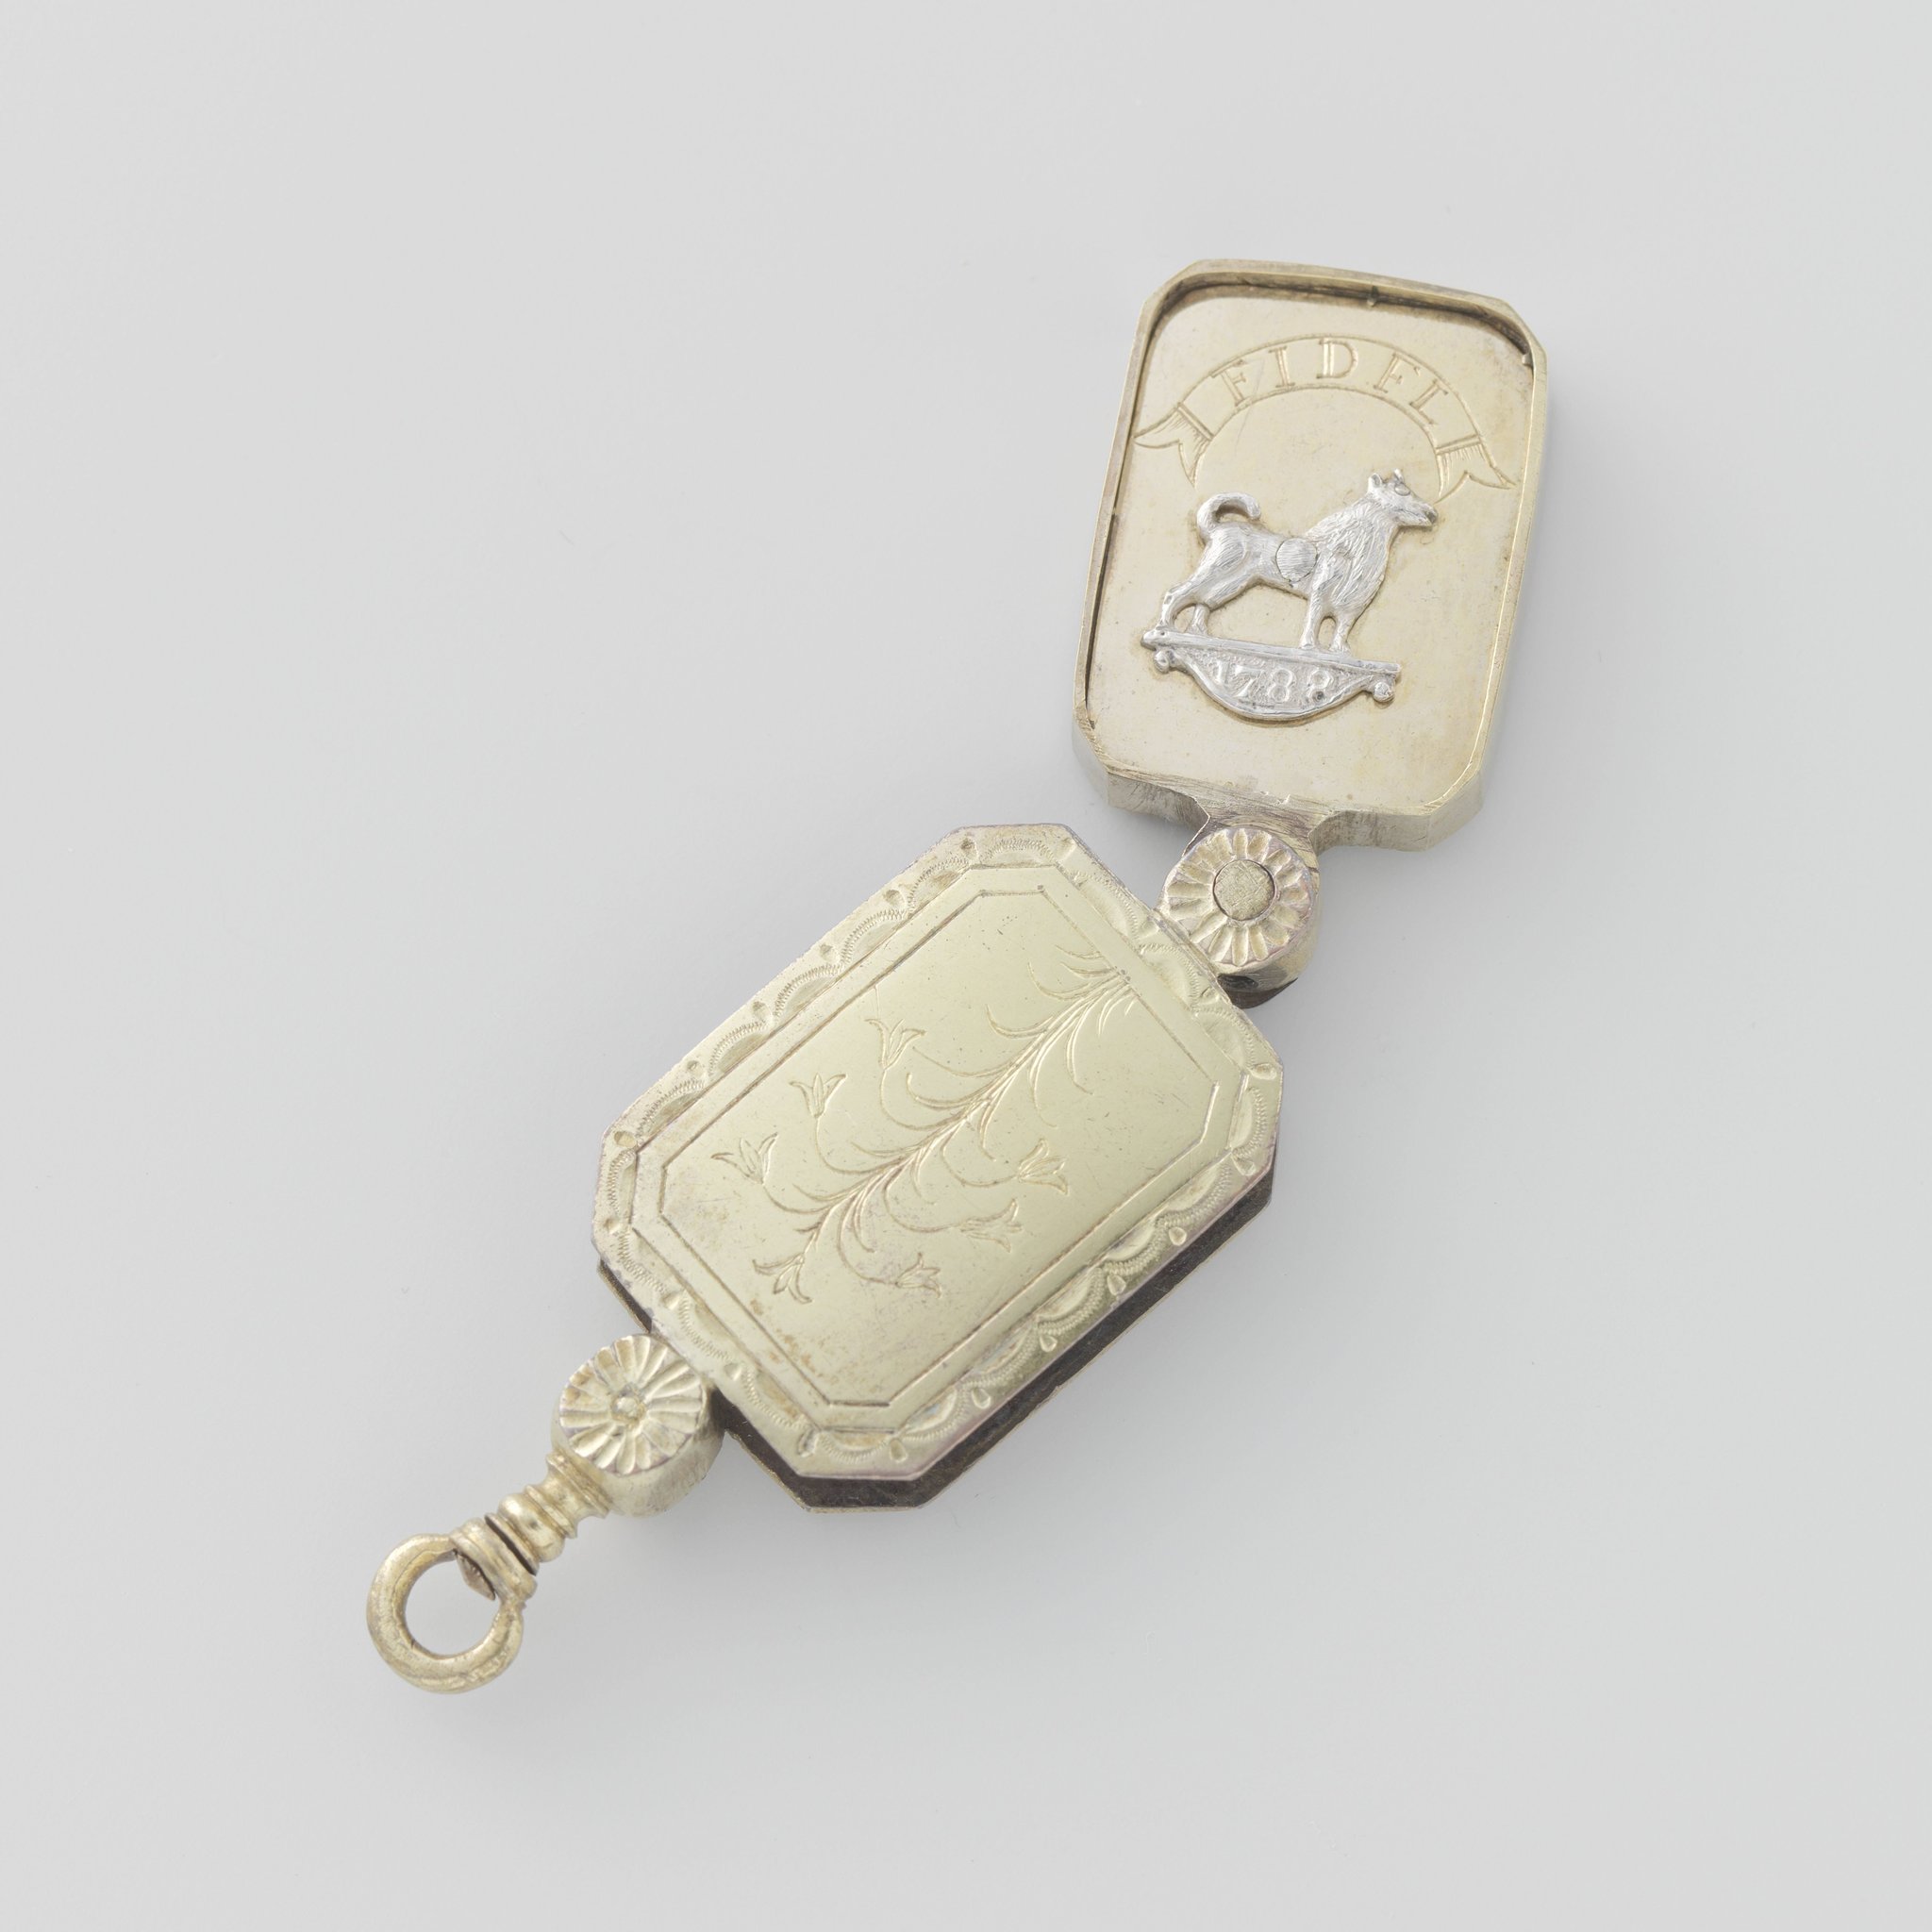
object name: case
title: Keeshondje, draagteken ter ere van Hendrik Danielsz. Hooft, burgemeester van Amsterdam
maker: Anonymous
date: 1788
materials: copper, silver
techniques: engraving, fastening, gilding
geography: netherlands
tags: amsterdam, mayor, hendrik danielsz. hooft, dog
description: Badge with spitz dog.